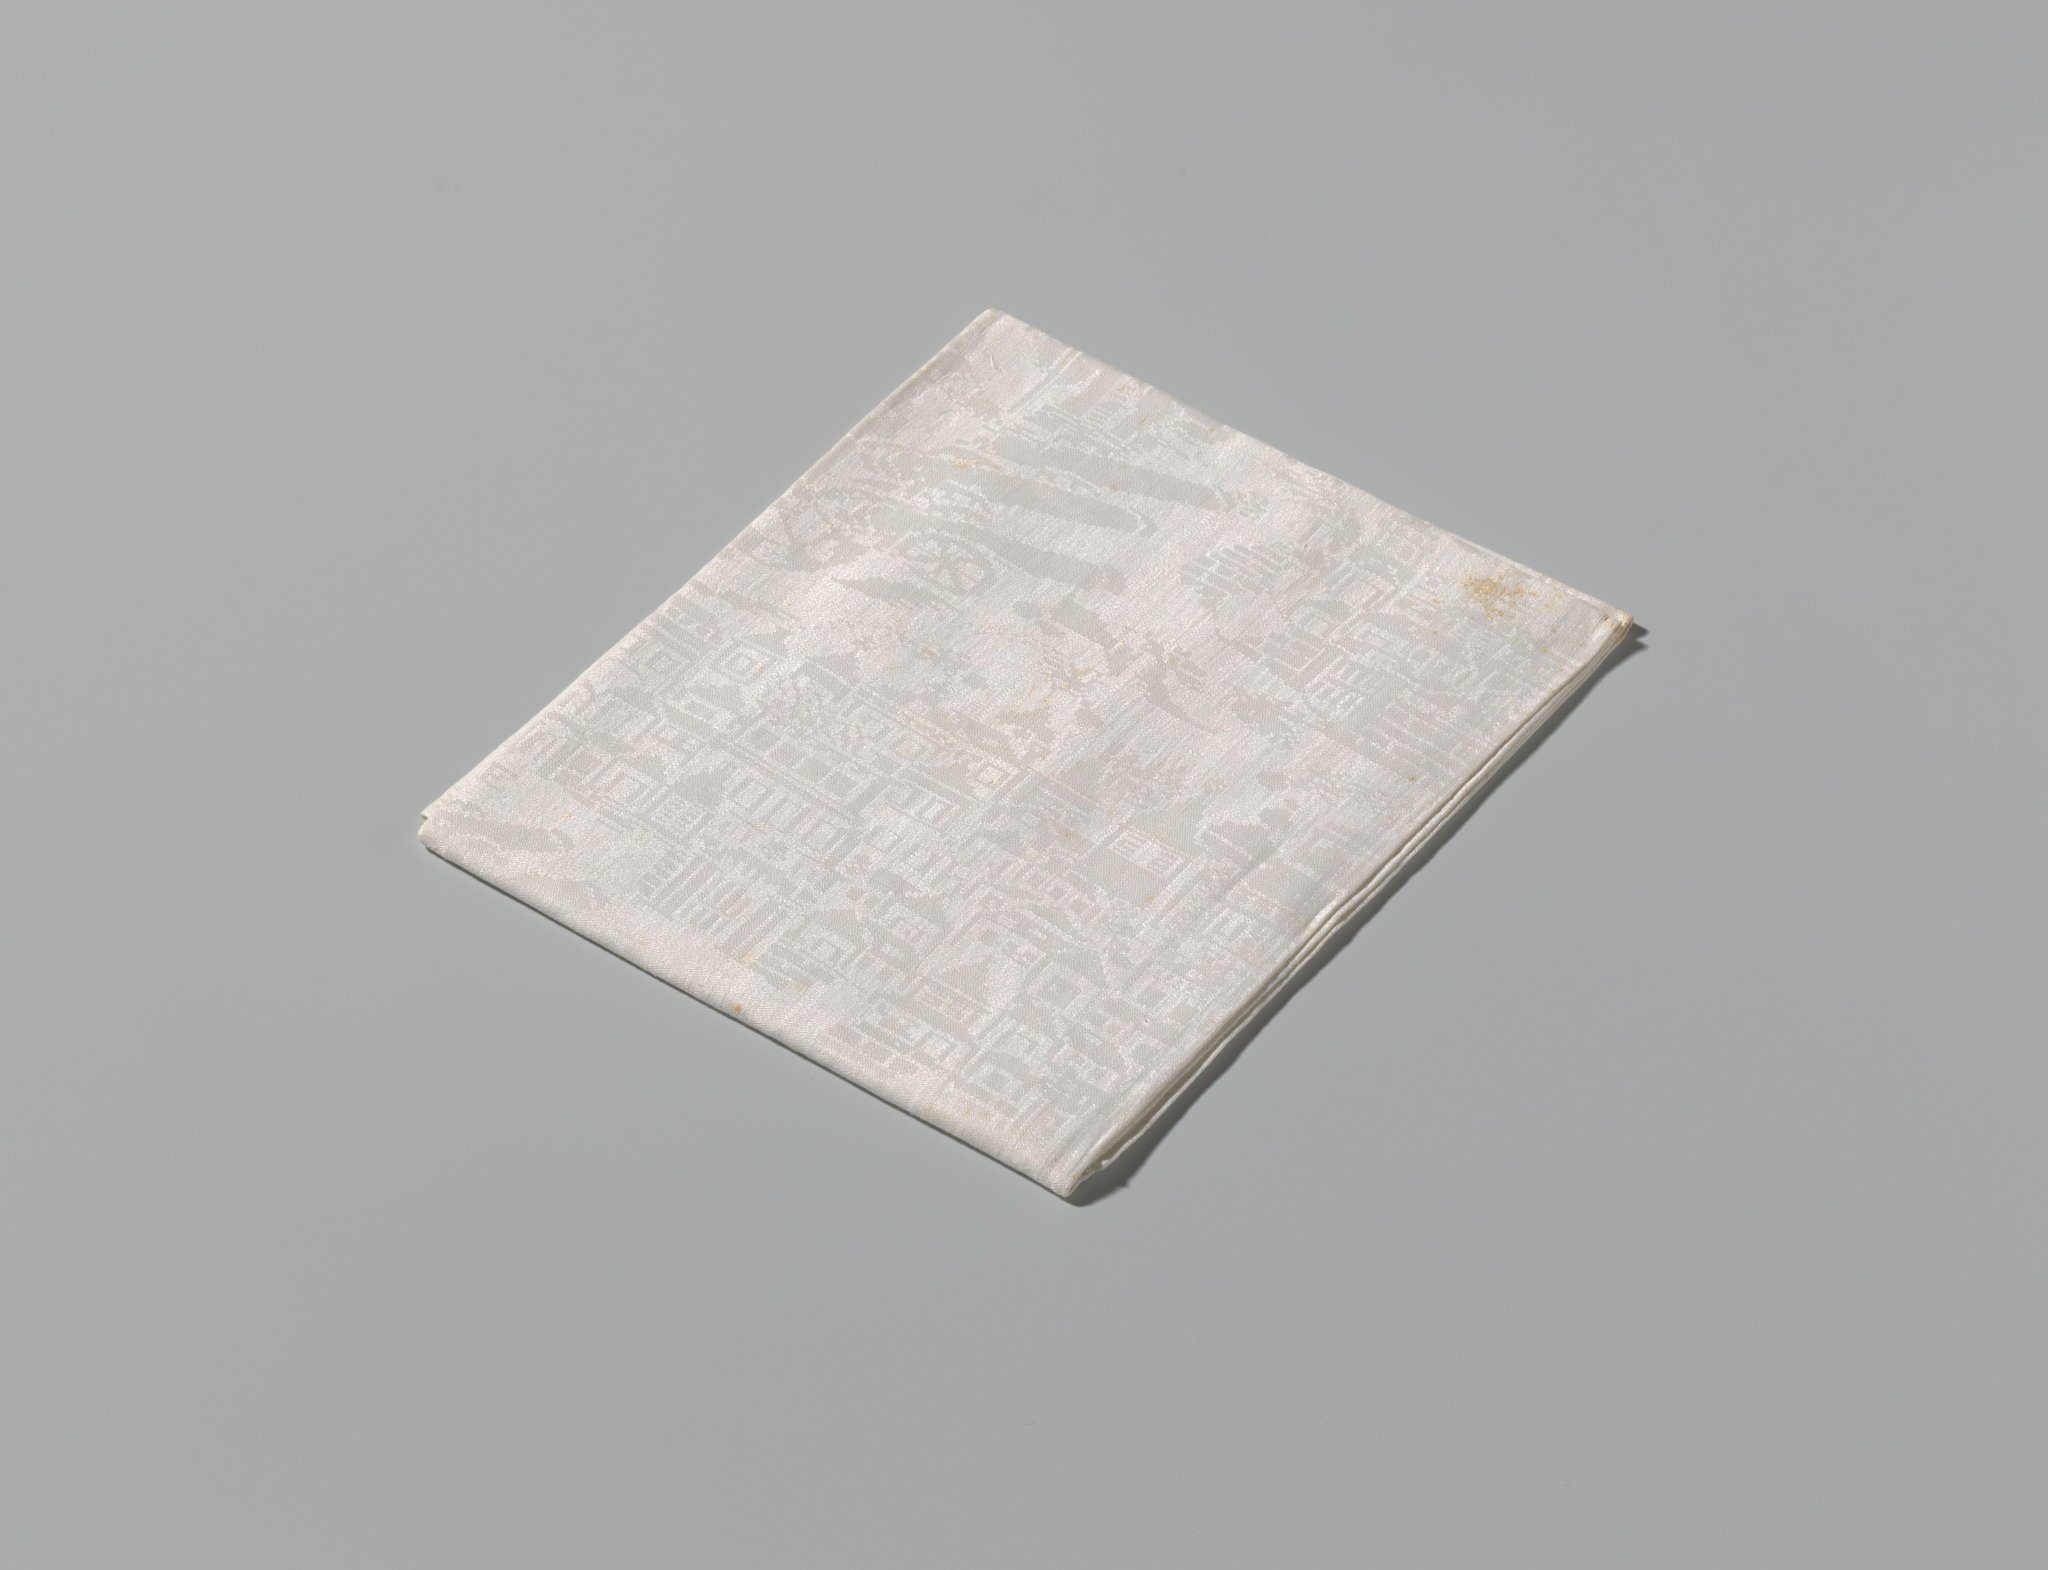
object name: napkin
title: Servet van wit linnendamast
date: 1708-1709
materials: linen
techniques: damask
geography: flanders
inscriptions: mark: ‘B’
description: Wit linnen damasten servet met de verovering van Lille en het inschrift "PRINCEPS EVGENIUS INSVLAS DEBELLAVIT 1708", gemerkt B.